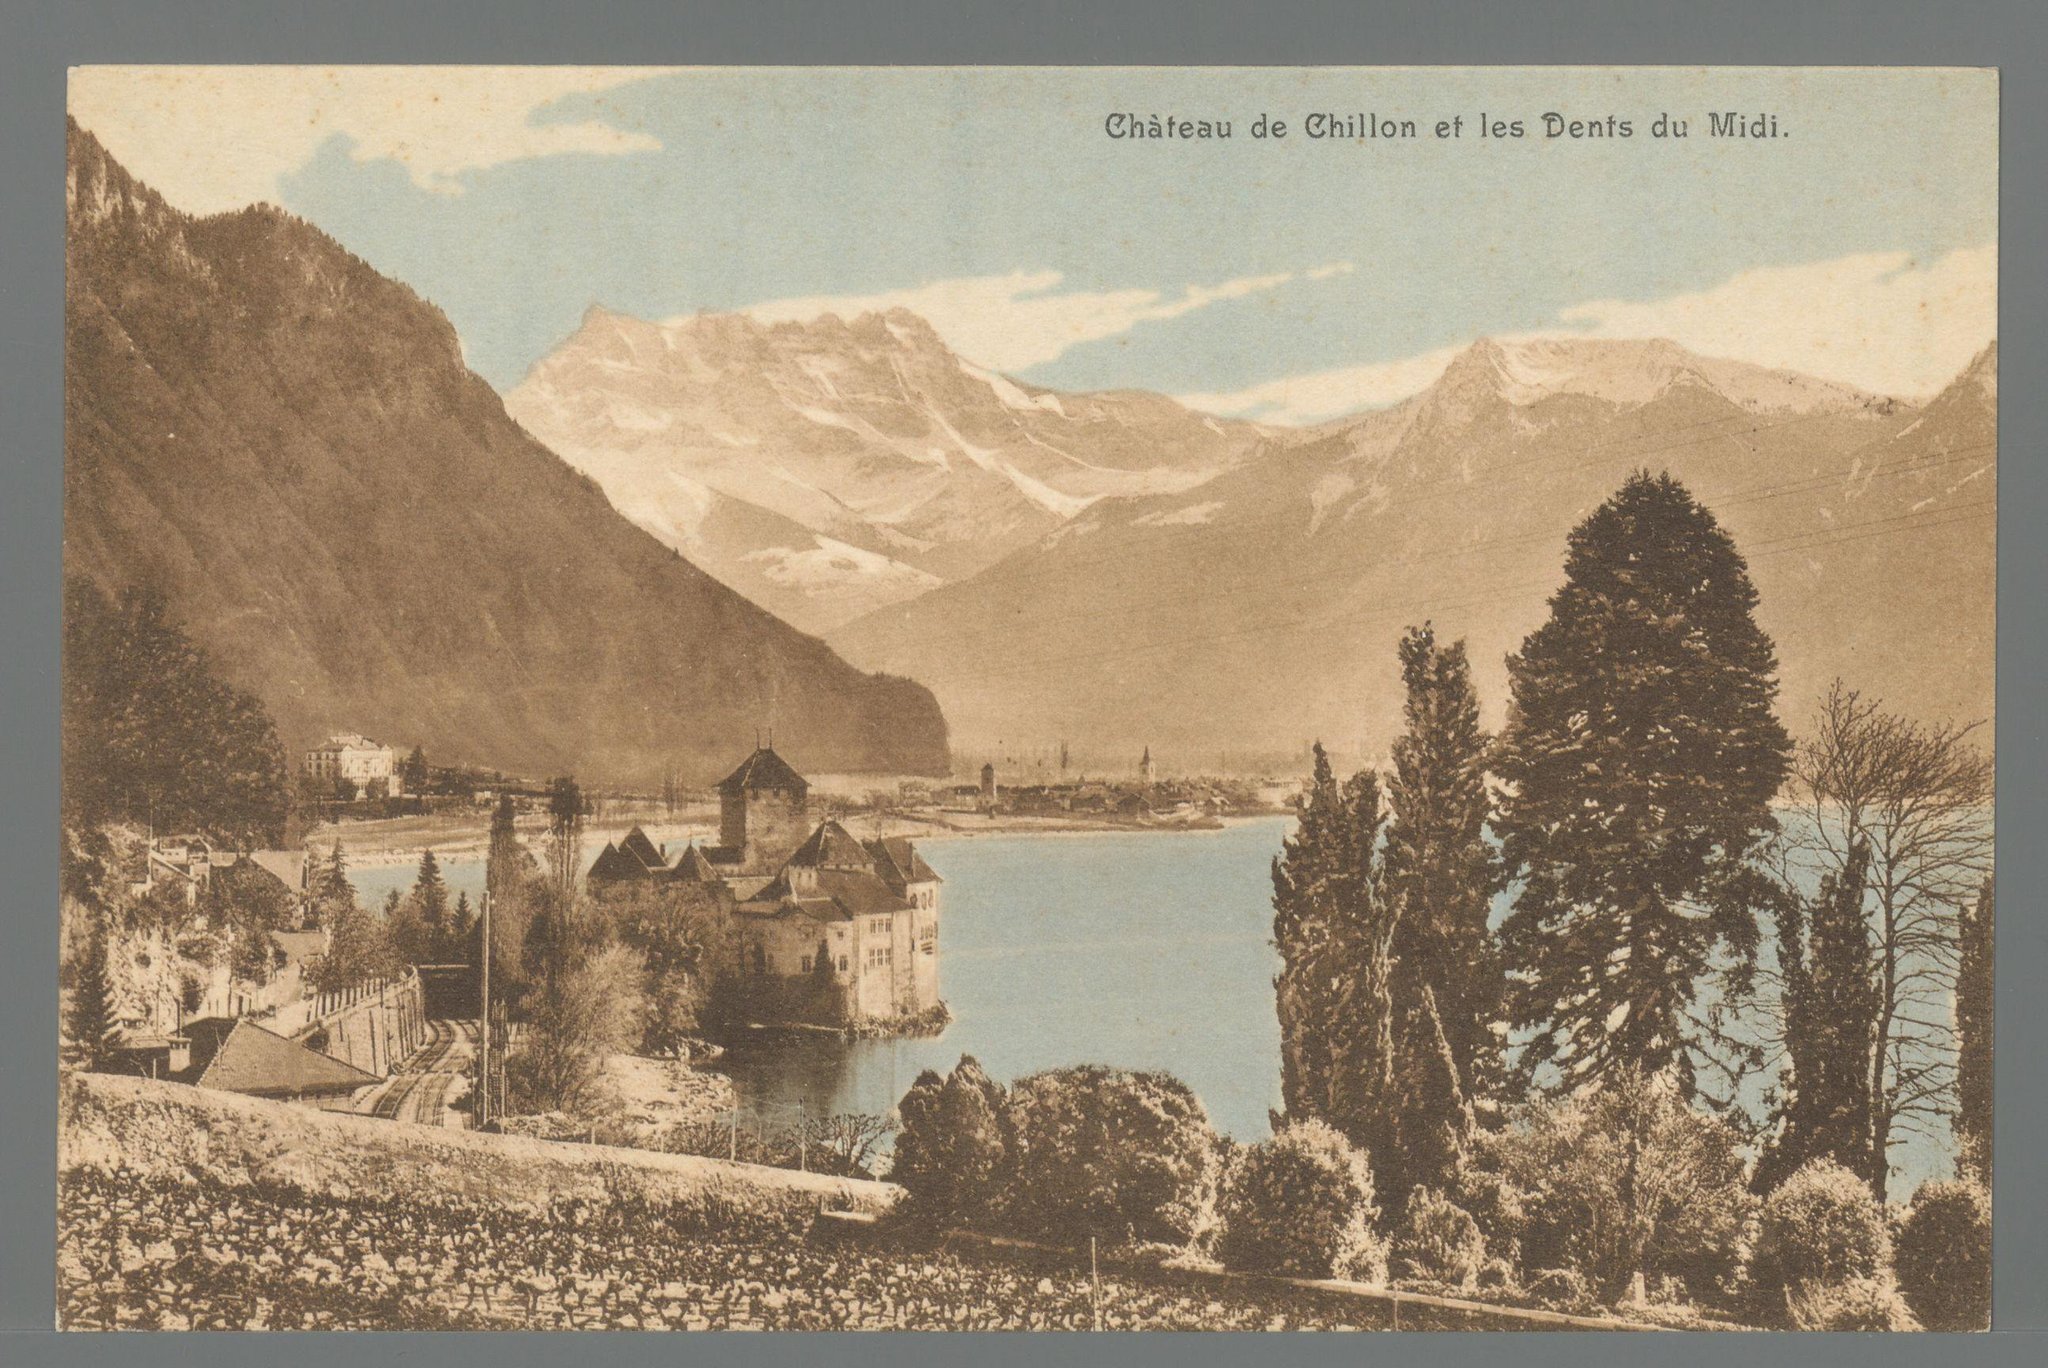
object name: photomechanical print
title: Château de Chillon et les Dents du Midi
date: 1905-1930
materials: cardboard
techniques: photograph, lithograph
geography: montreux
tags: castle, lake, mountain-range, snow peaks